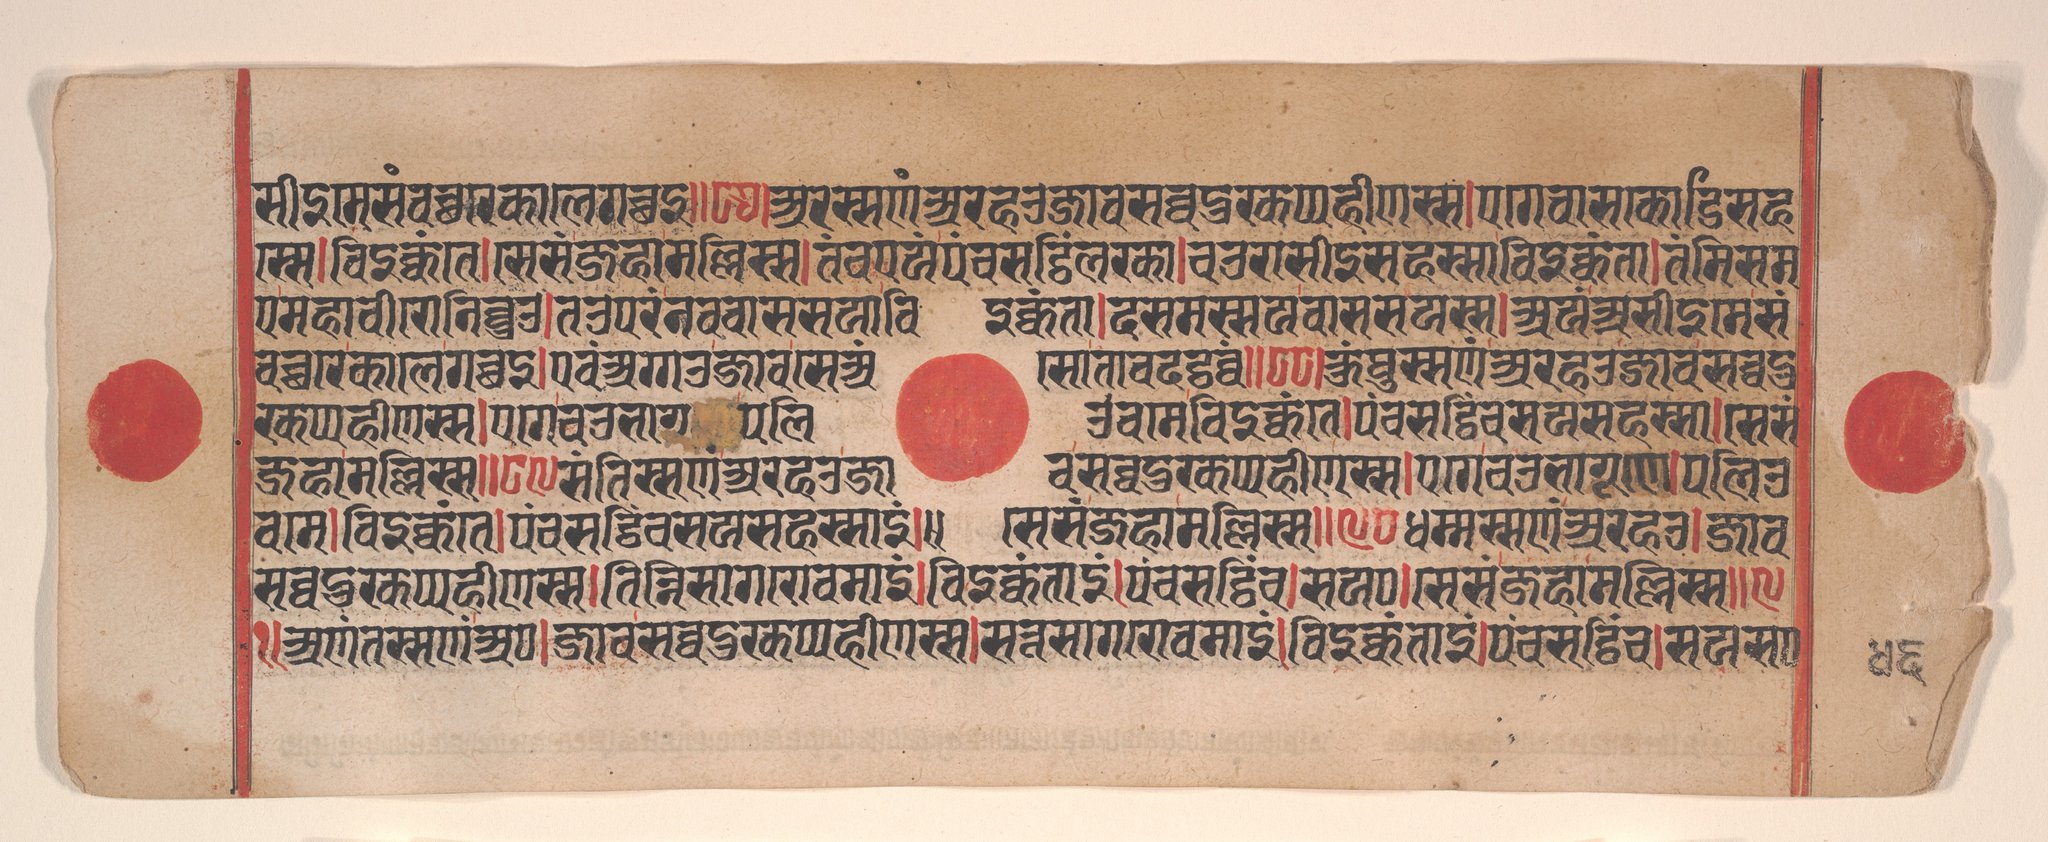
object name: folio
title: Leaf from a Kalpa Sutra (Jain Book of Rituals)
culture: indian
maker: bhadrabahu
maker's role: artist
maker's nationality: indian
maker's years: 356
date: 1401-1500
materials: gold, ink, paper, watercolor